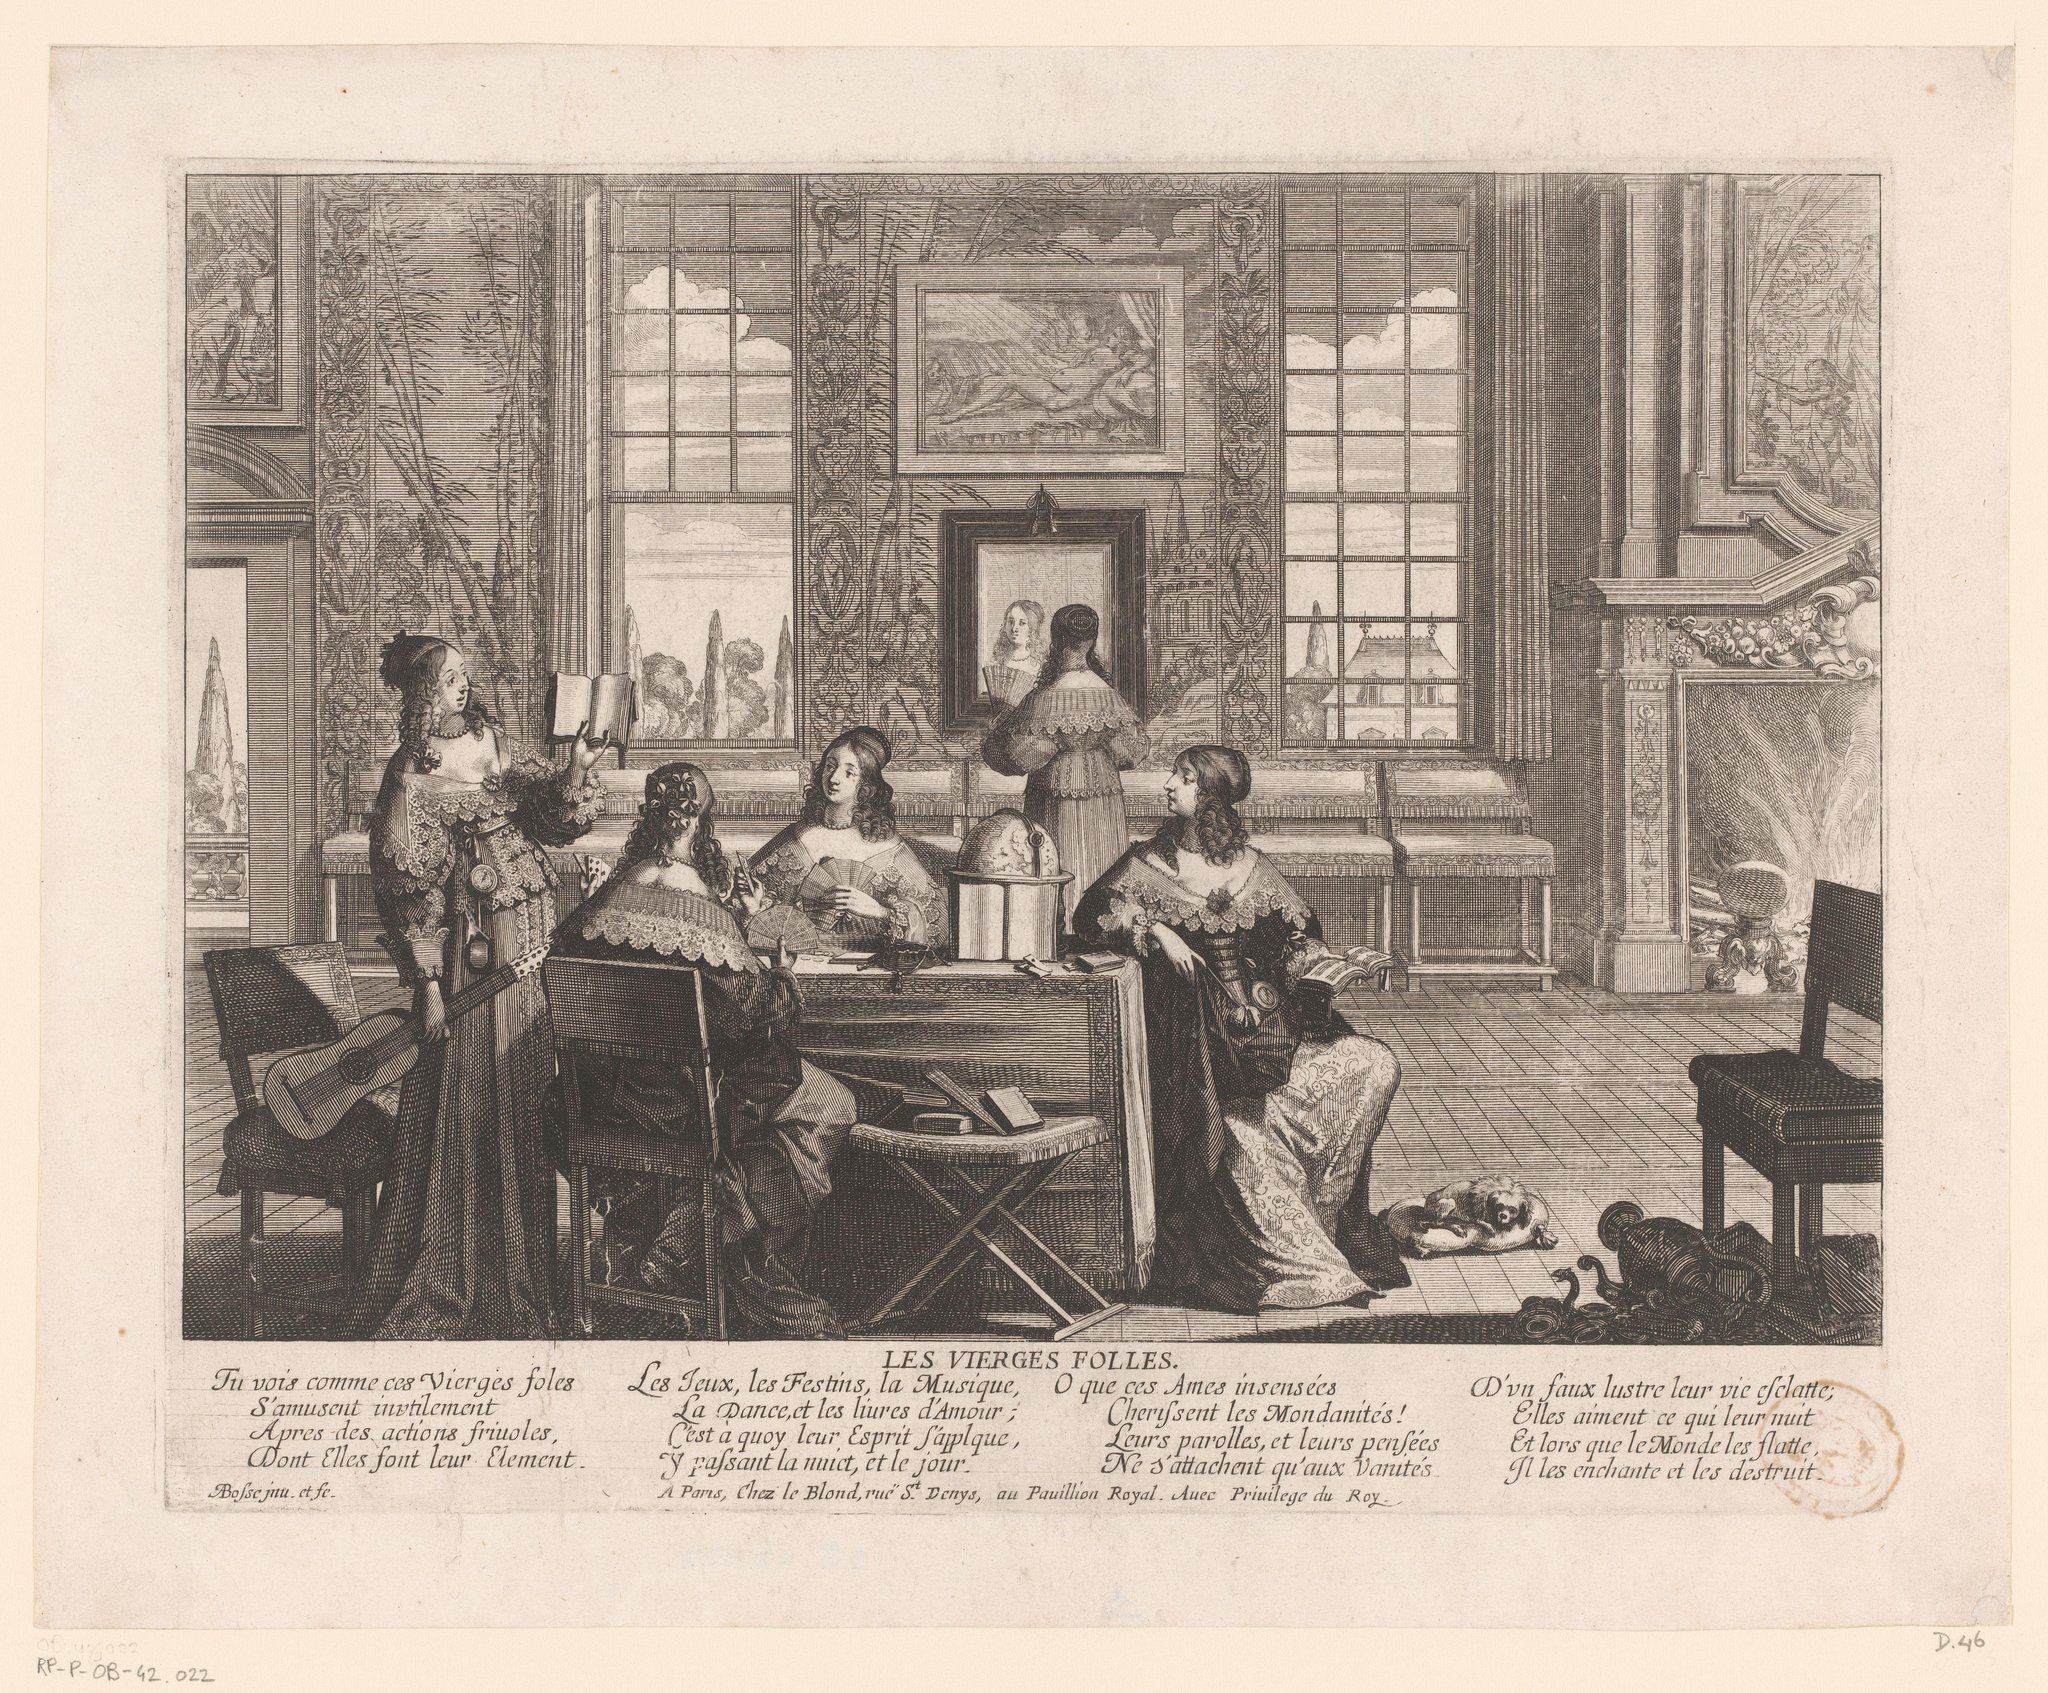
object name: print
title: Gelijkenis van de wijze en dwaze maagden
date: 1638-1640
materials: paper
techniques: engraving, etching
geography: paris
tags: looking in the mirror; contemplation of own beauty, the wise and the foolish virgins ~ parable of christ (matthew 25:1-13), playing-cards, the parable of the prodigal son (luke 15:11-32)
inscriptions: collector's mark: Lugt 240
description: Maakt deel uit van een serie van zeven prenten met als onderwerp de parabel van de vijf wijze en de vijf dwaze maagden. De eerste staat werd uitgegeven door Jean Leblond (I) en een tweede staat door de weduwe van Poilly.